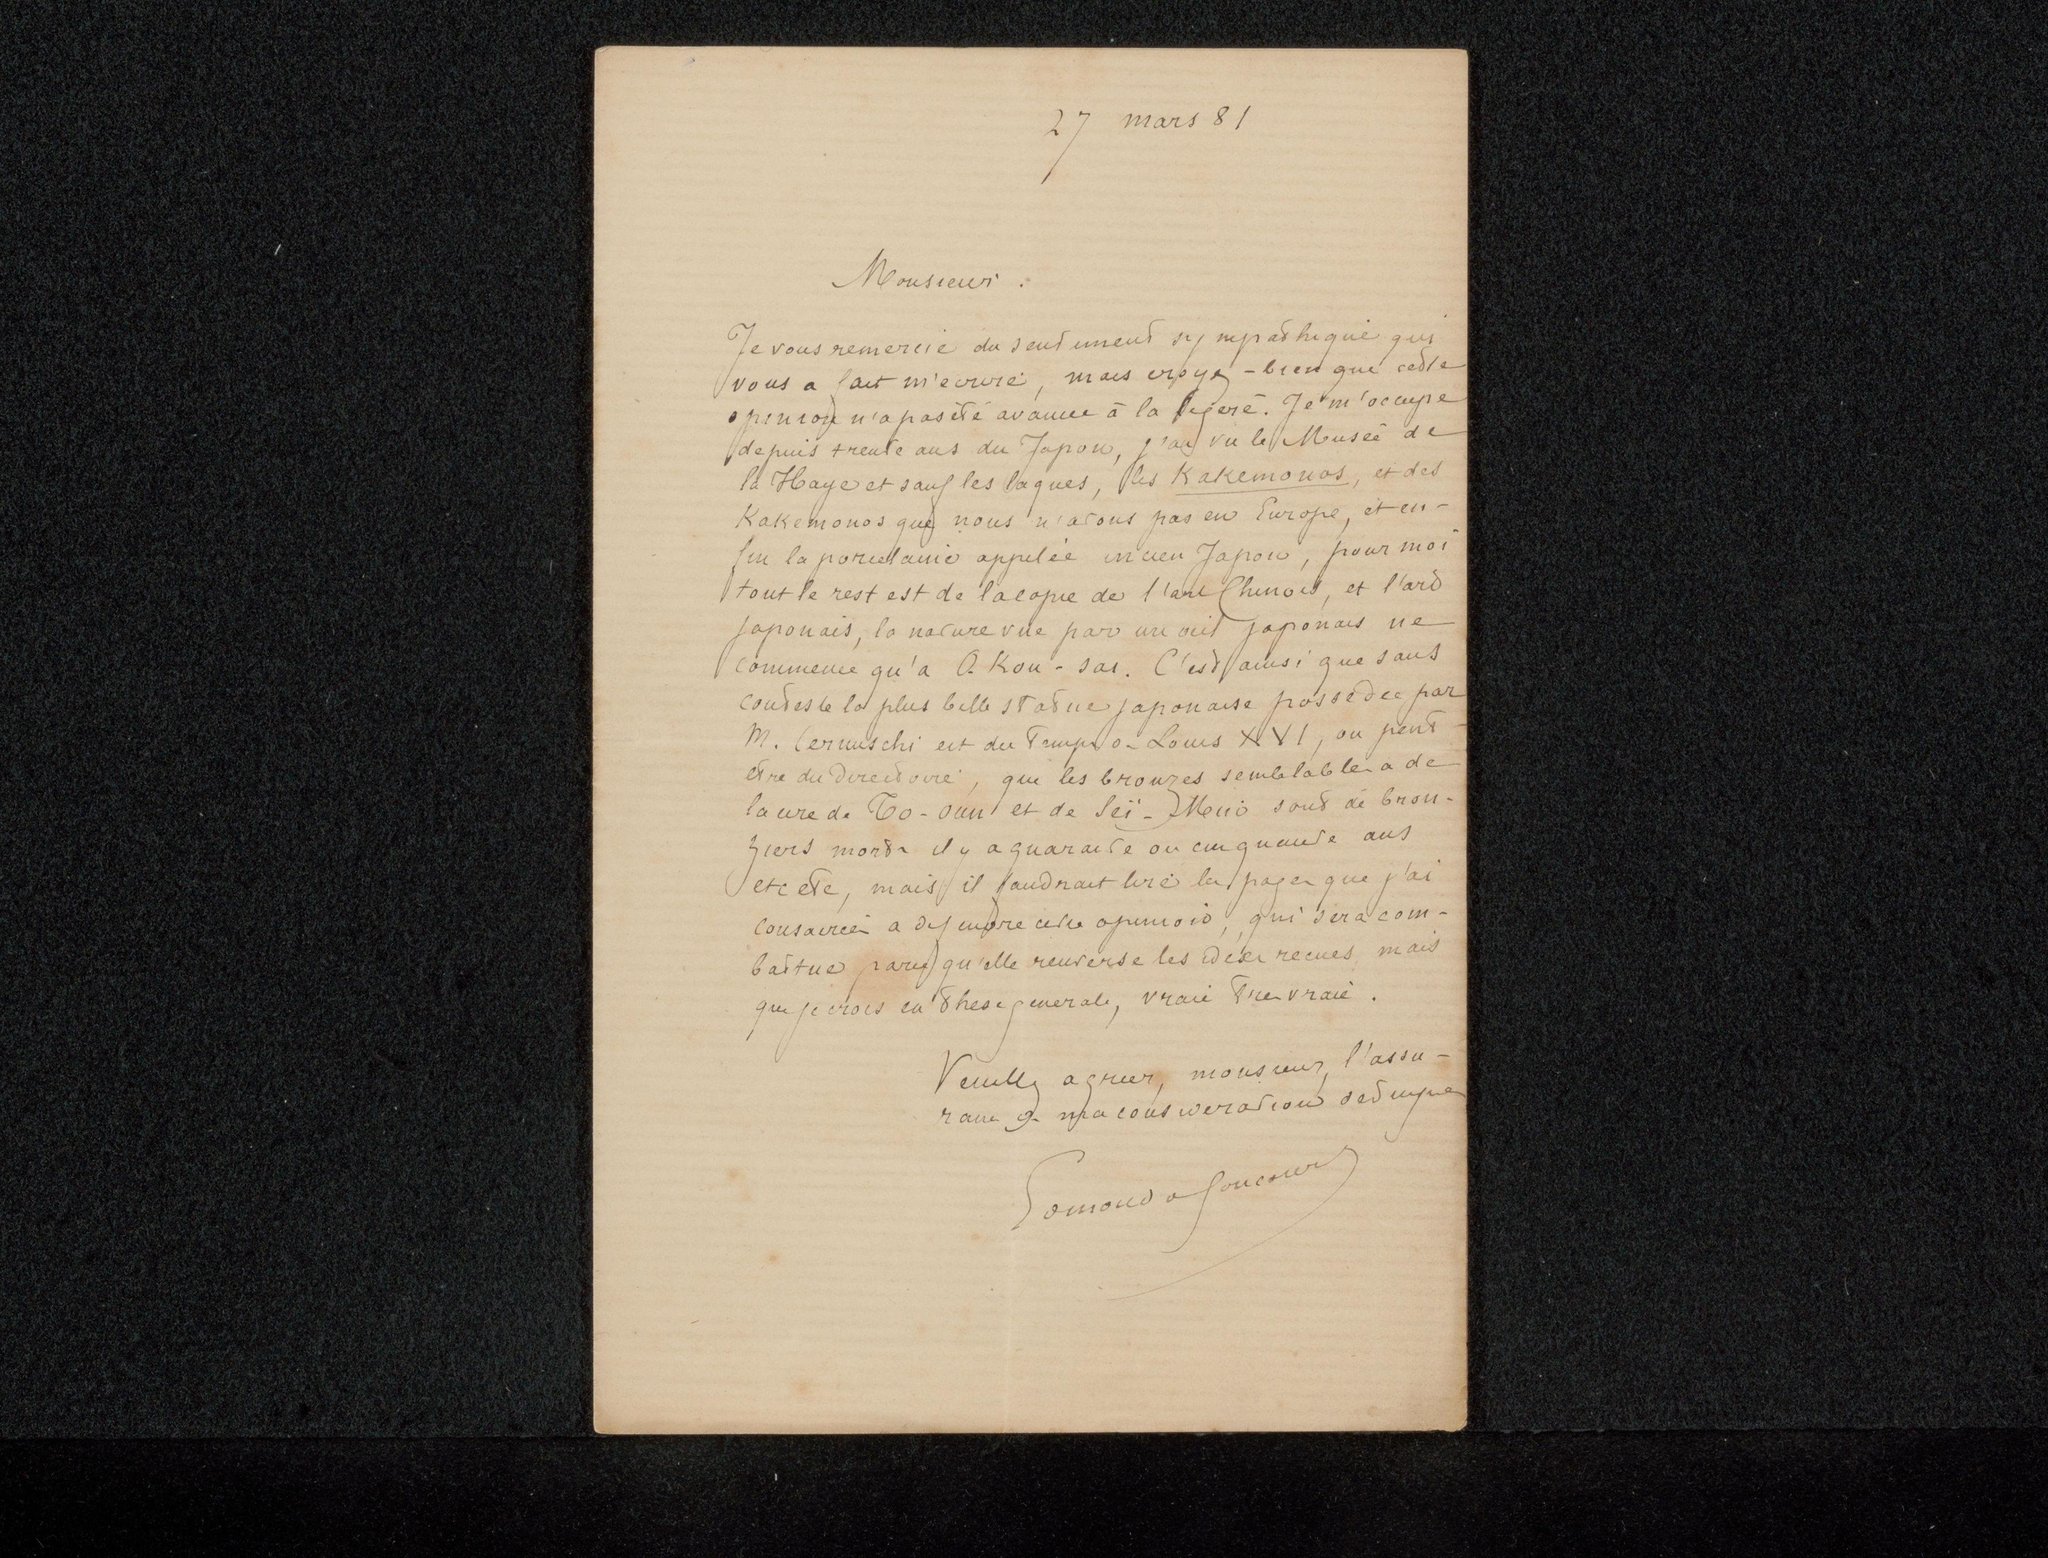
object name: letter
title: Brief aan Philip Zilcken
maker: edmond de goncourt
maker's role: draughtsman, painter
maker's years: 1822-1896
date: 1881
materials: ink, paper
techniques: pen, writing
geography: paris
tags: philip zilcken, permanent exhibition, museum, the hague, japan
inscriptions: collector's mark: ‘RPK’